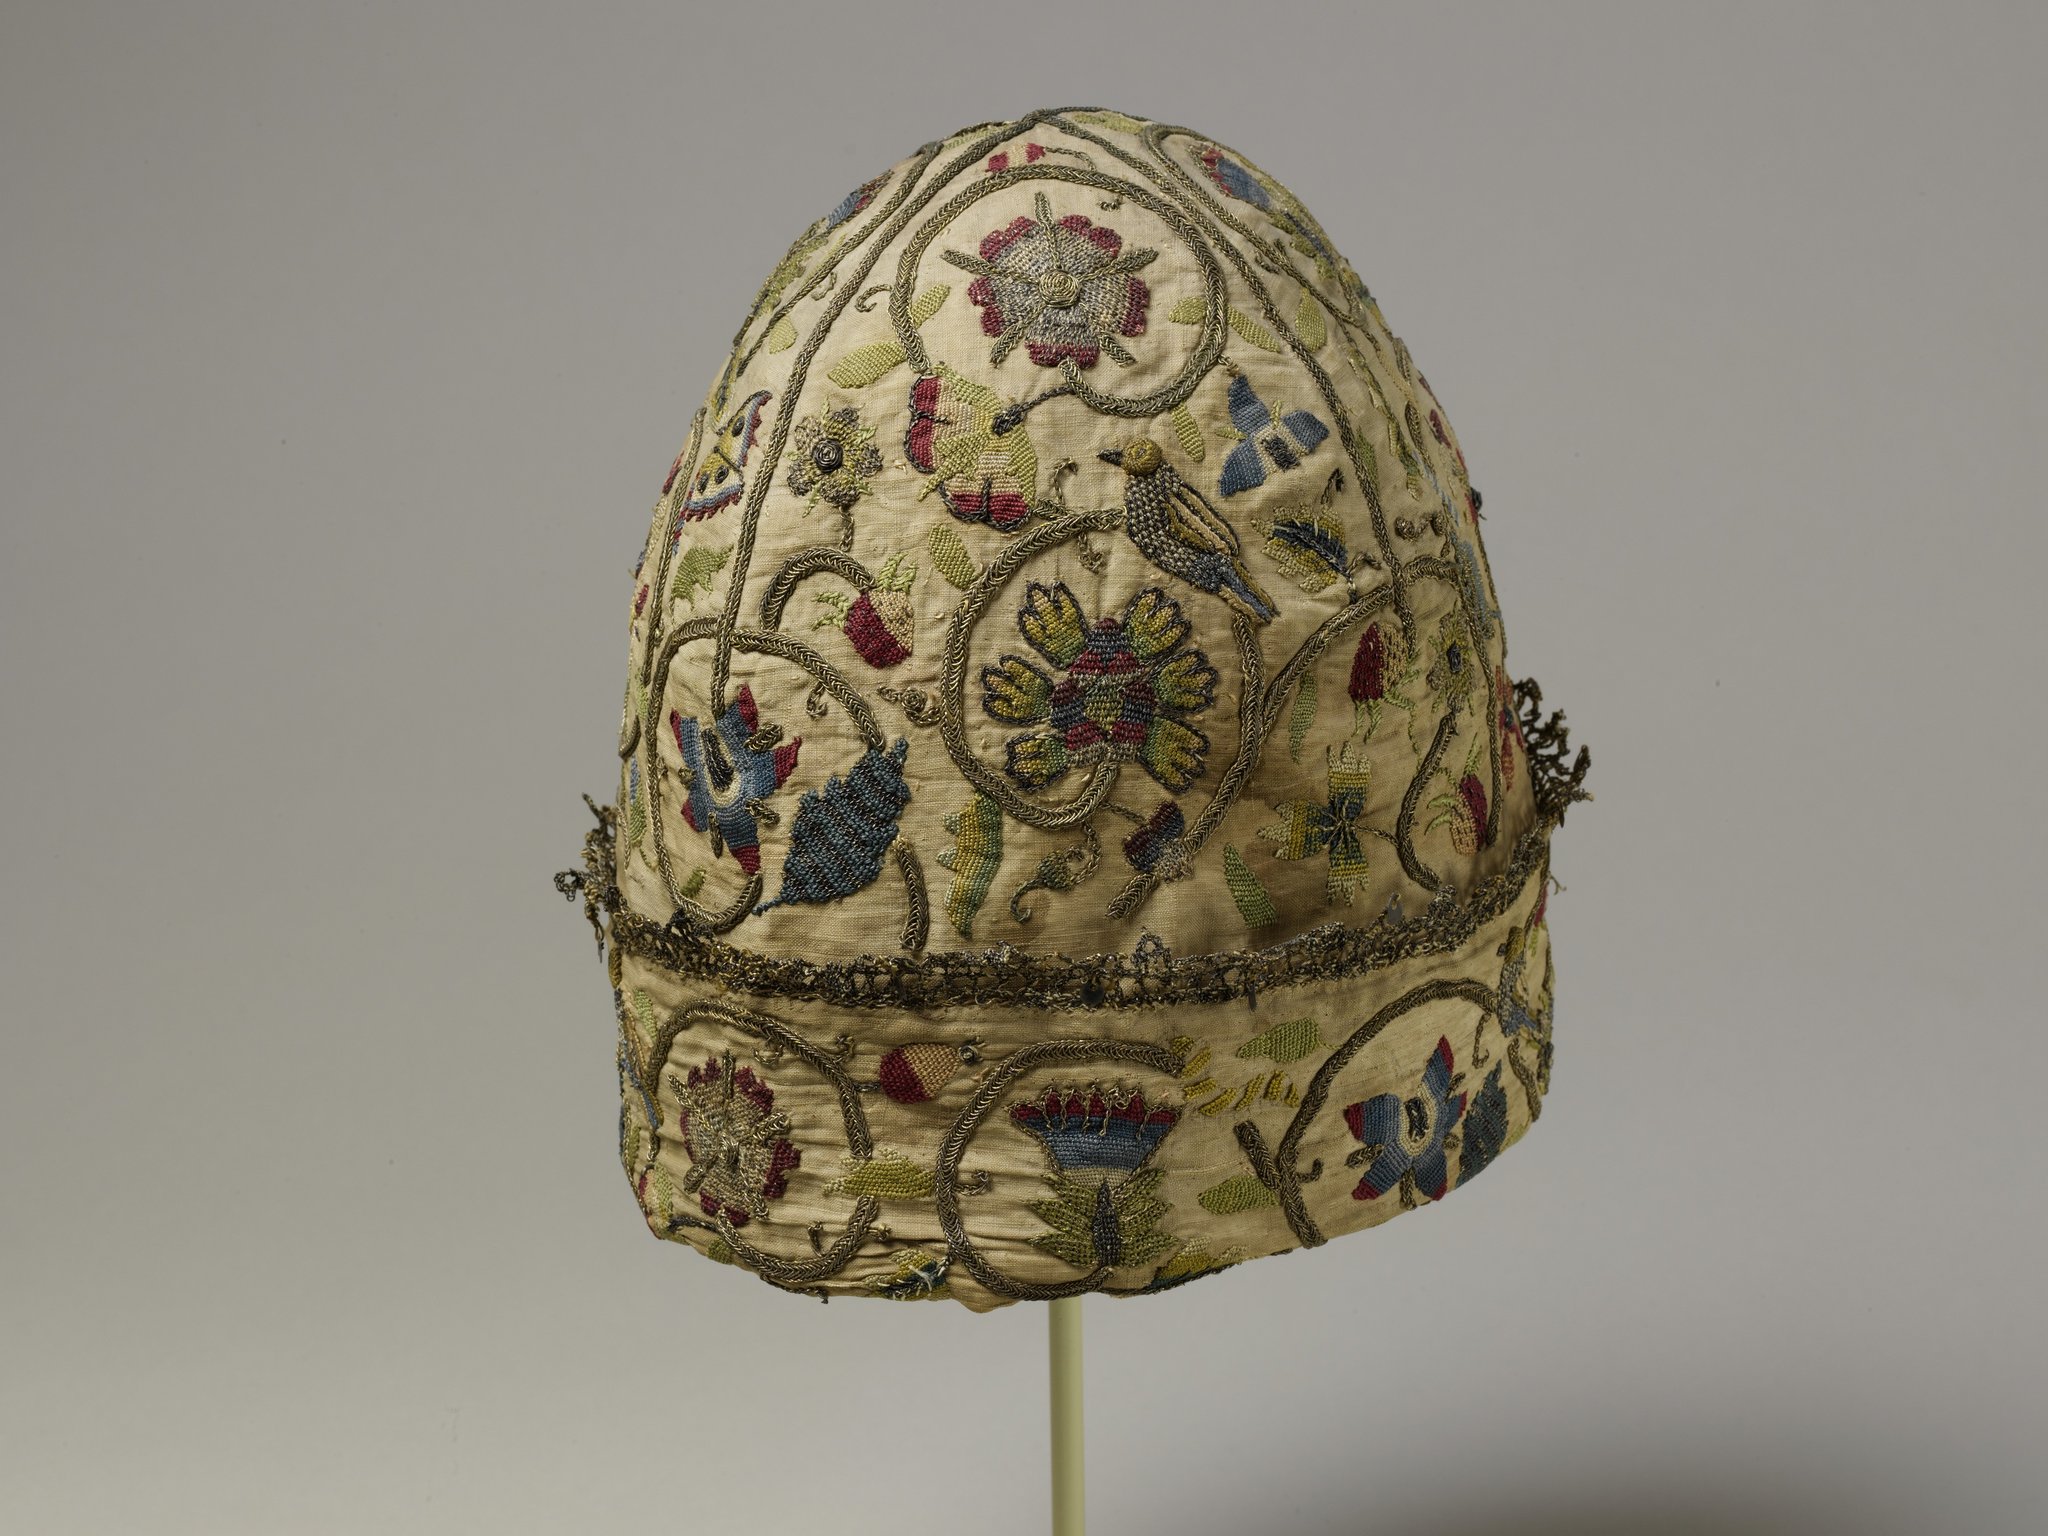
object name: night cap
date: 1600-1620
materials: linen, metal thread, silk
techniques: embroidery, stitching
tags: birds,flowers